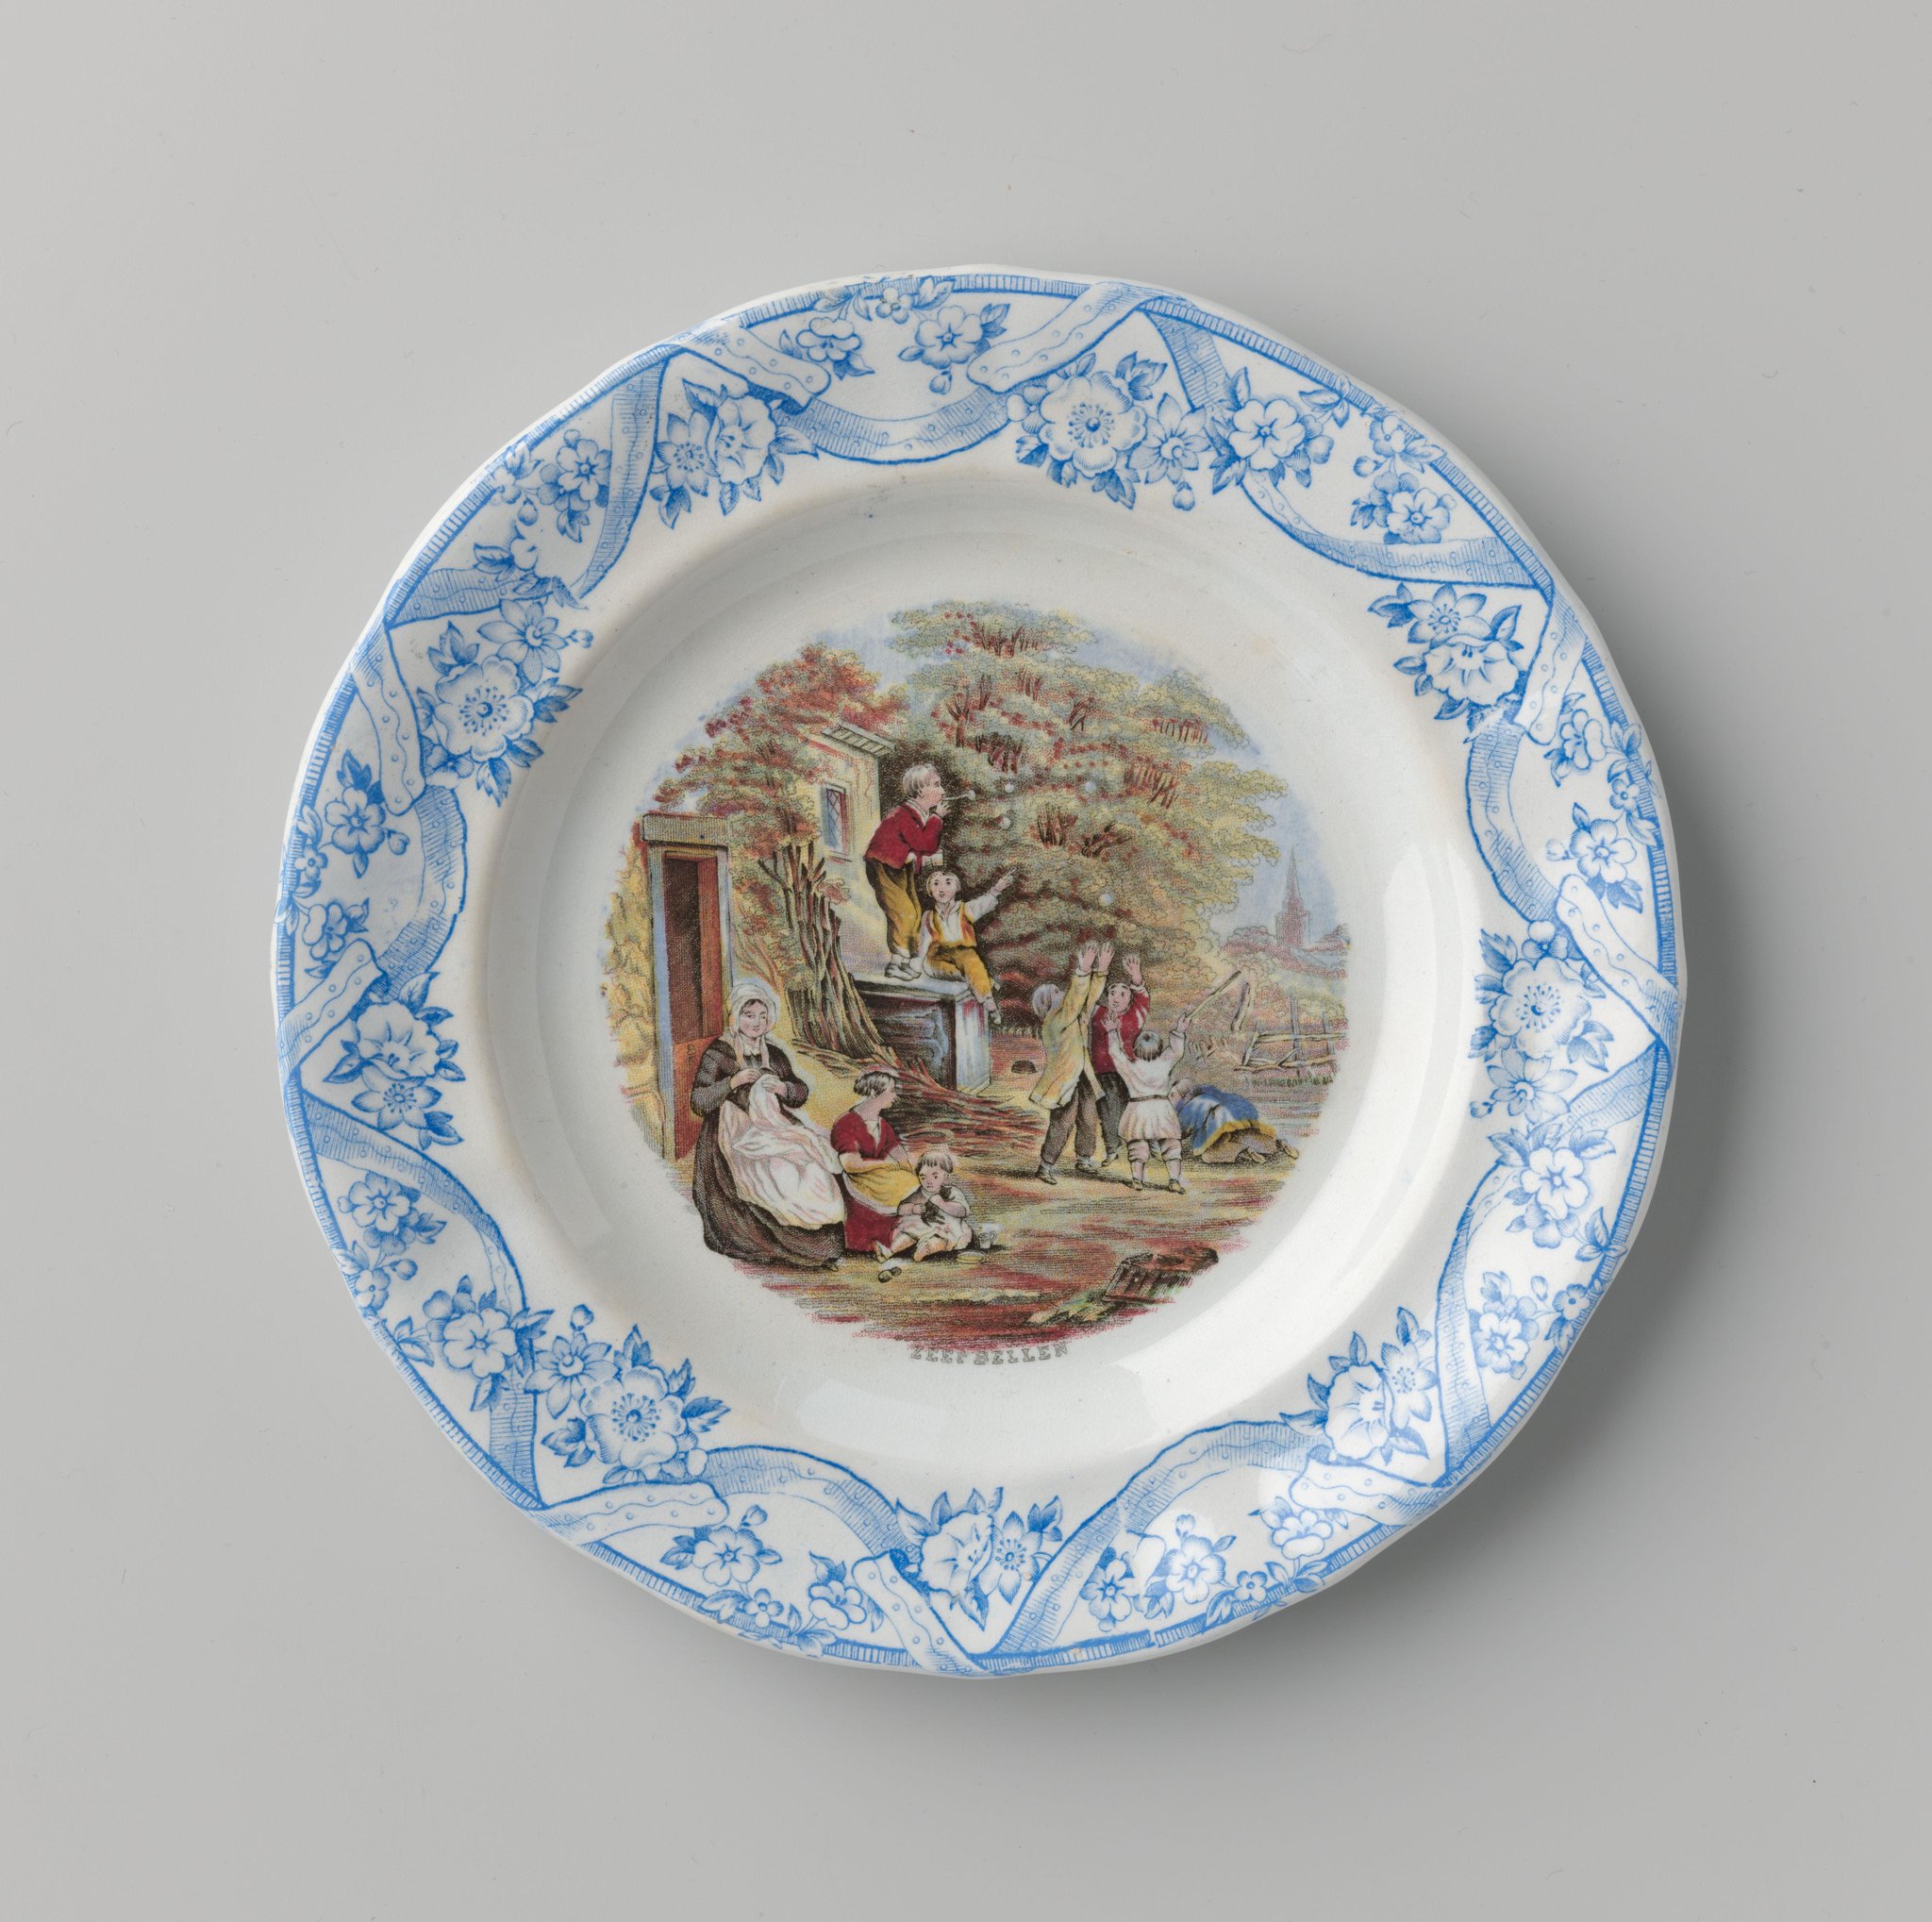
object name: plate dish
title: Bord, met op het plat bellenblasende kinderen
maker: petrus regout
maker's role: plateelbakker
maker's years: 1801-1879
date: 1879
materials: creamware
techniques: transfer decoration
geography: maastricht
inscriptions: check stamp: ‘N en F’, mark: ‘staffordshire knot // 1851 // PRIZE MEDIAL // PETRUS REGOUT // MAASTRICHT’, inscription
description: Bord van aardewerk met veelkleurig transferdecor. Op het plat bellenblasende kinderen voor een huis. Onder de vorrstelling staat de tekst: ZEEPBELLEN. De rand is in blauw gedecoreerd met een golvende rand waaraan guirlandes en een lint hangen.